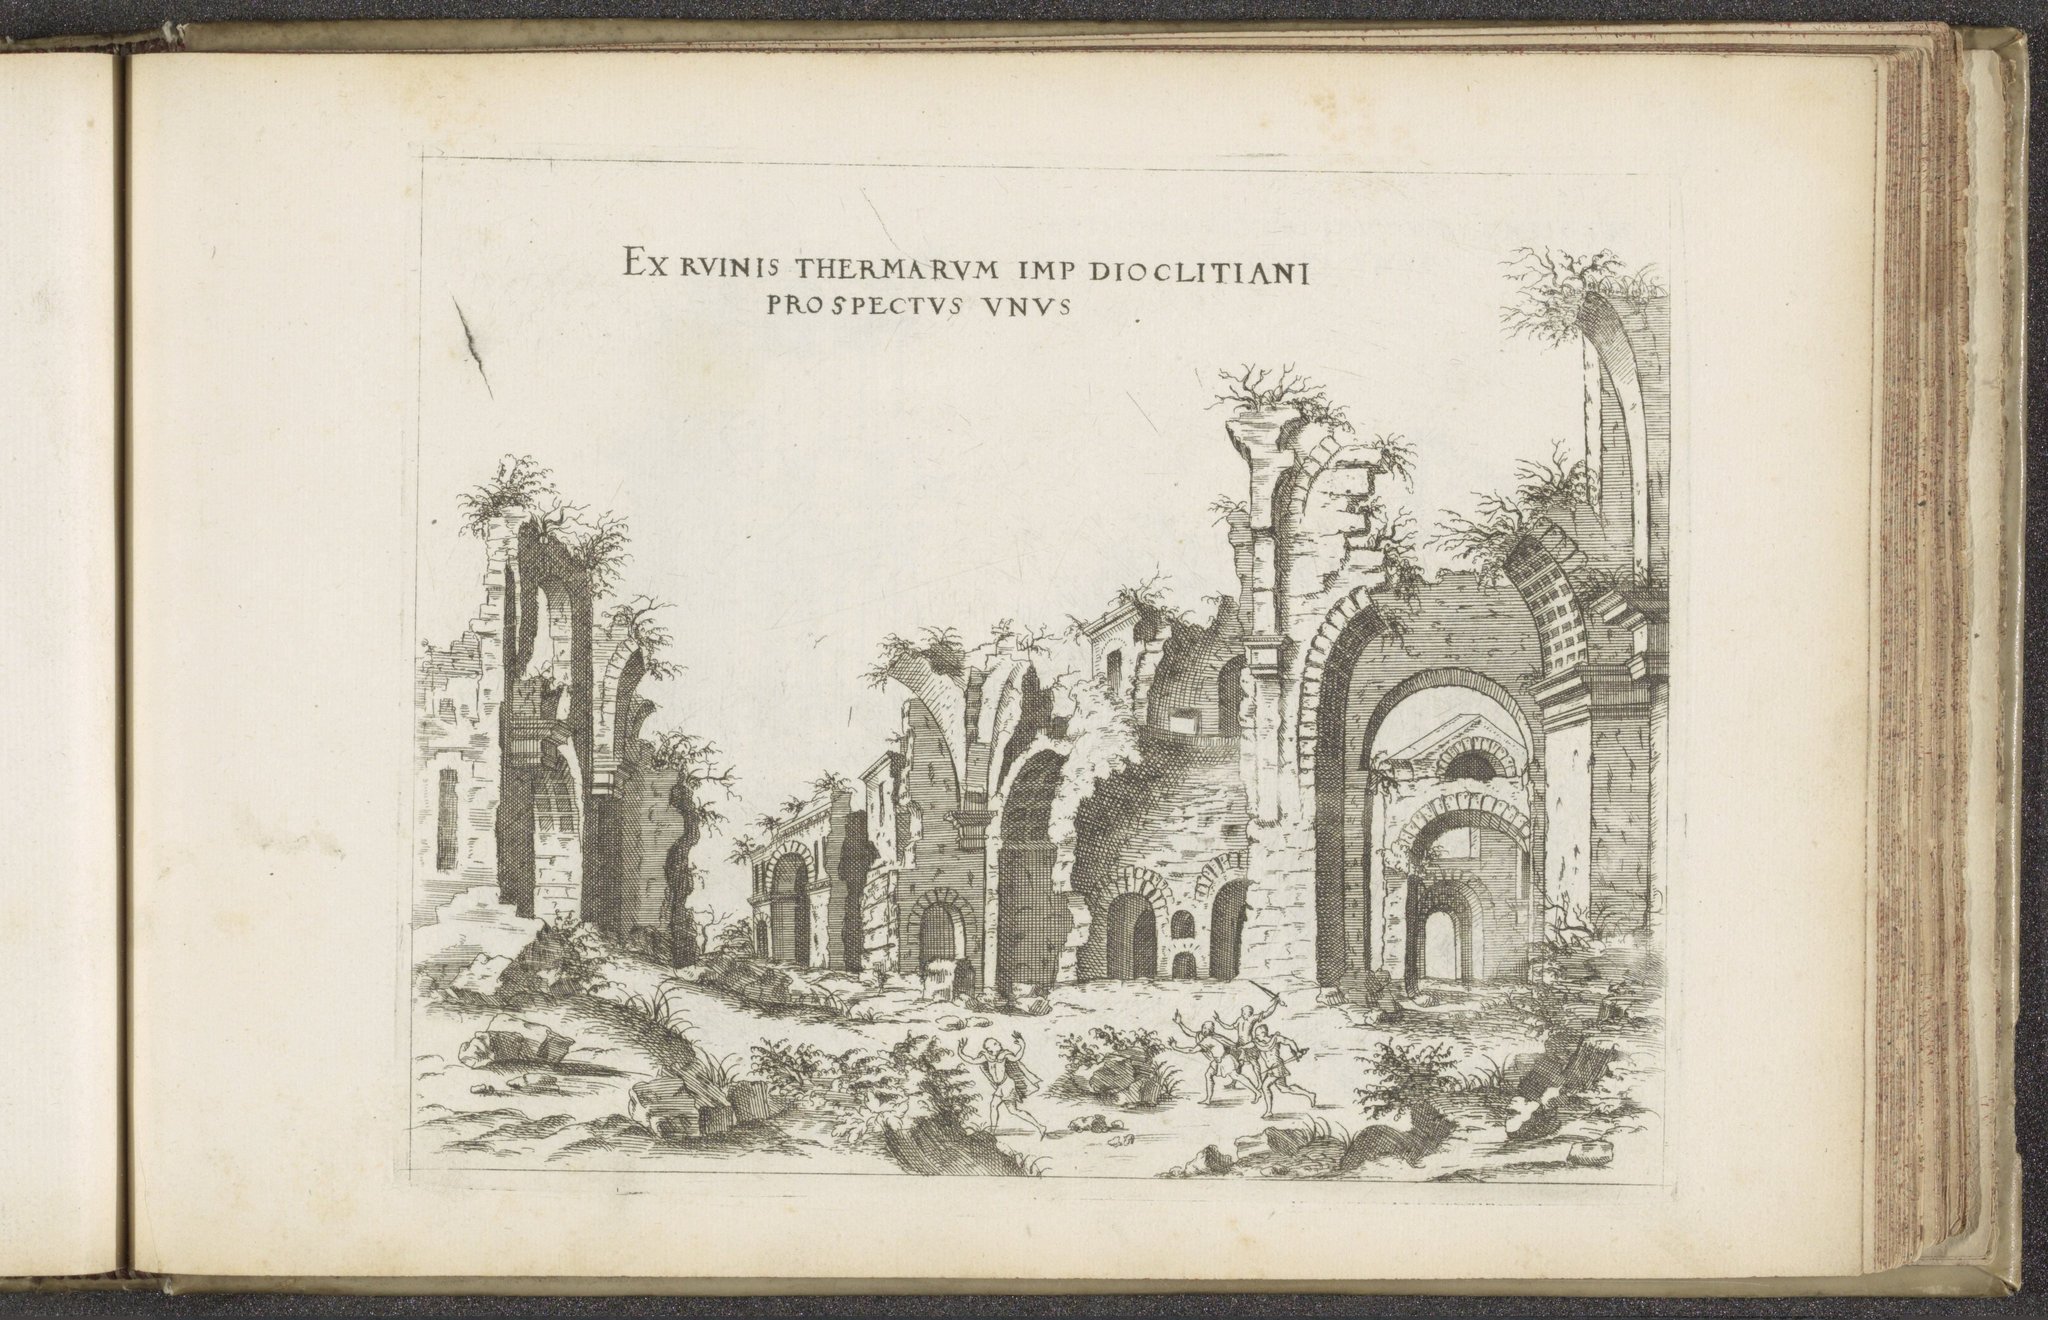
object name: print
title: Romeinse ruïnes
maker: jacques androuet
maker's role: draughtsman, print maker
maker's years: 1515-1584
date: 1551-1584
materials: paper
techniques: etching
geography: france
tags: ruin of a building ~ architecture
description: Gezicht op de ruïnes van de Thermen van Diocletianus in Rome. Tussen de ruïnes lopen vier mannen. Twee mannen achtervolgen de andere twee mannen met zwaarden. Deze prent maakt deel uit van een album.